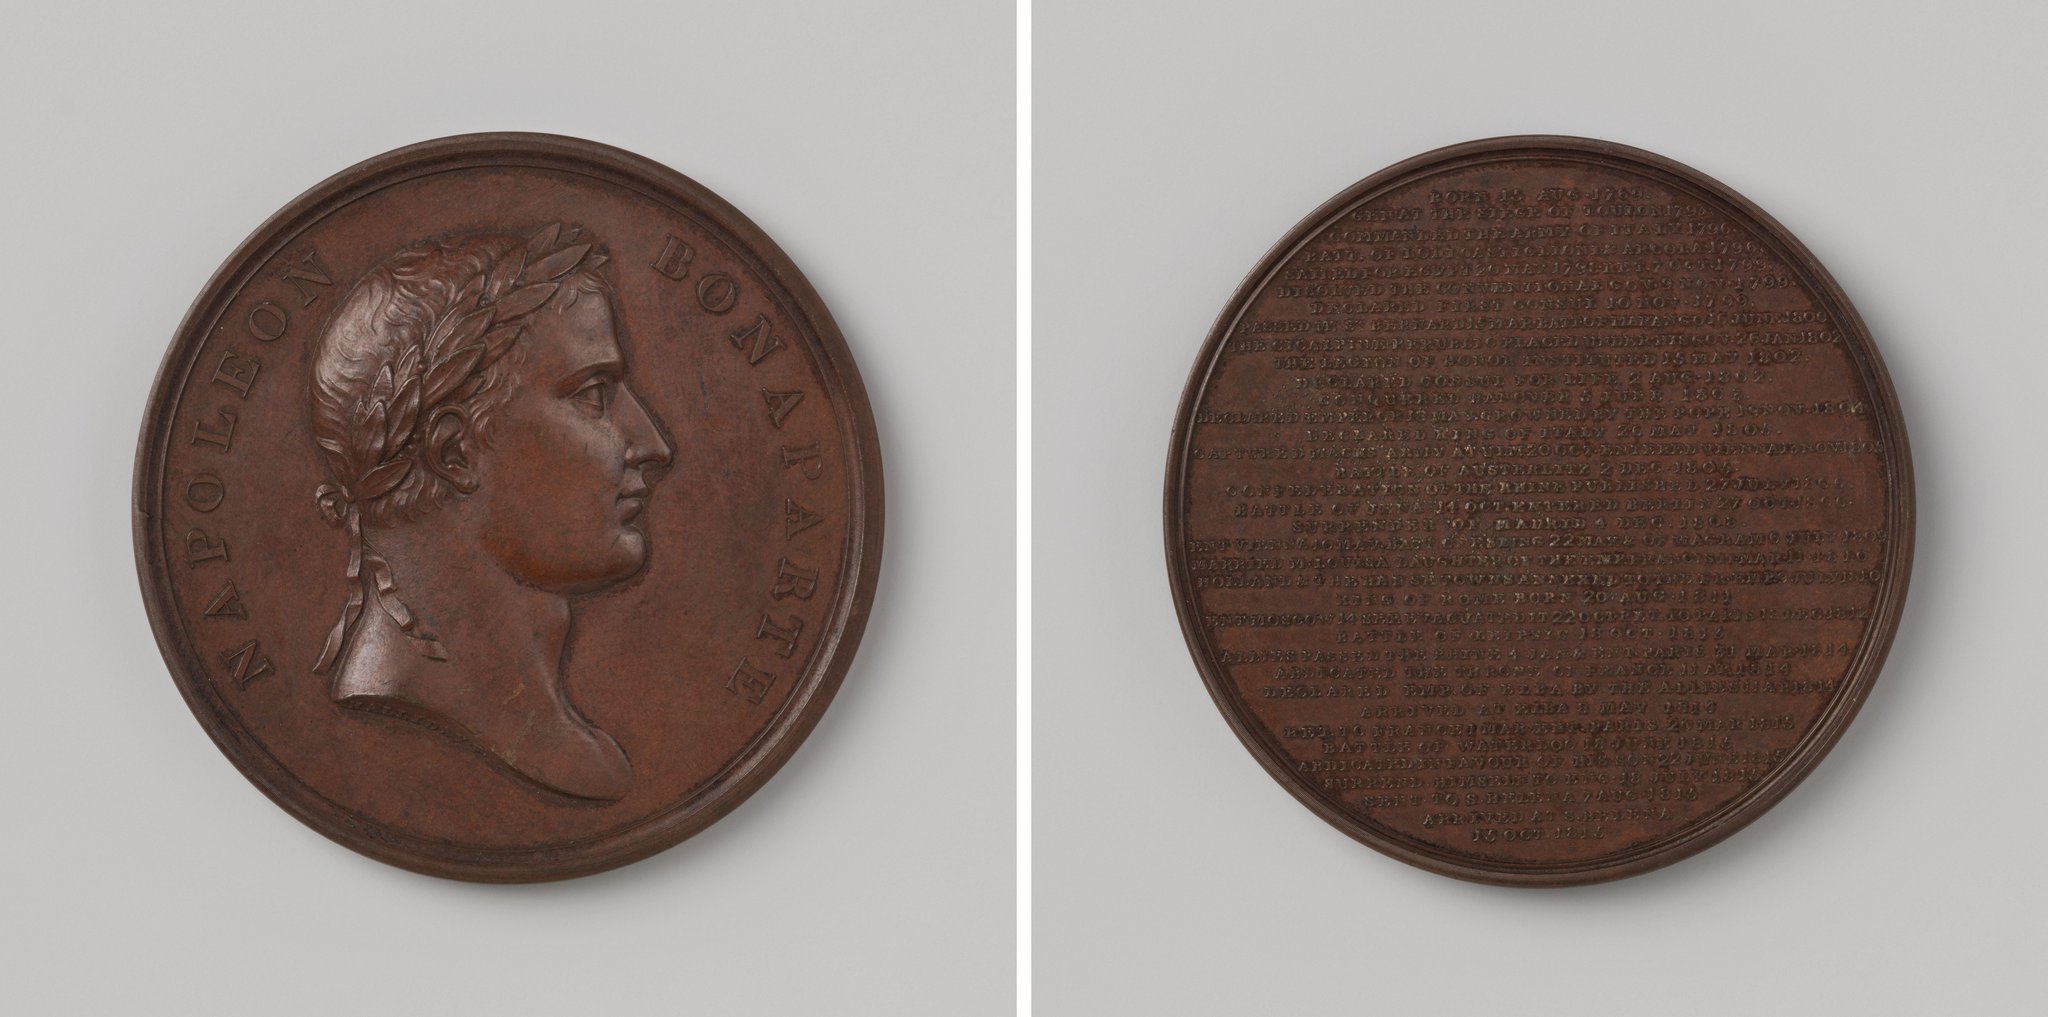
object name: history medal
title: Napoleon I Bonaparte, keizer der Fransen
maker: Anonymous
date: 1815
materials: bronze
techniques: striking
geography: france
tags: napoleon i (emperor of the french)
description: Bronzen penning. Voorzijde: borststuk man met lauwerkrans. Keerzijde: opschrift